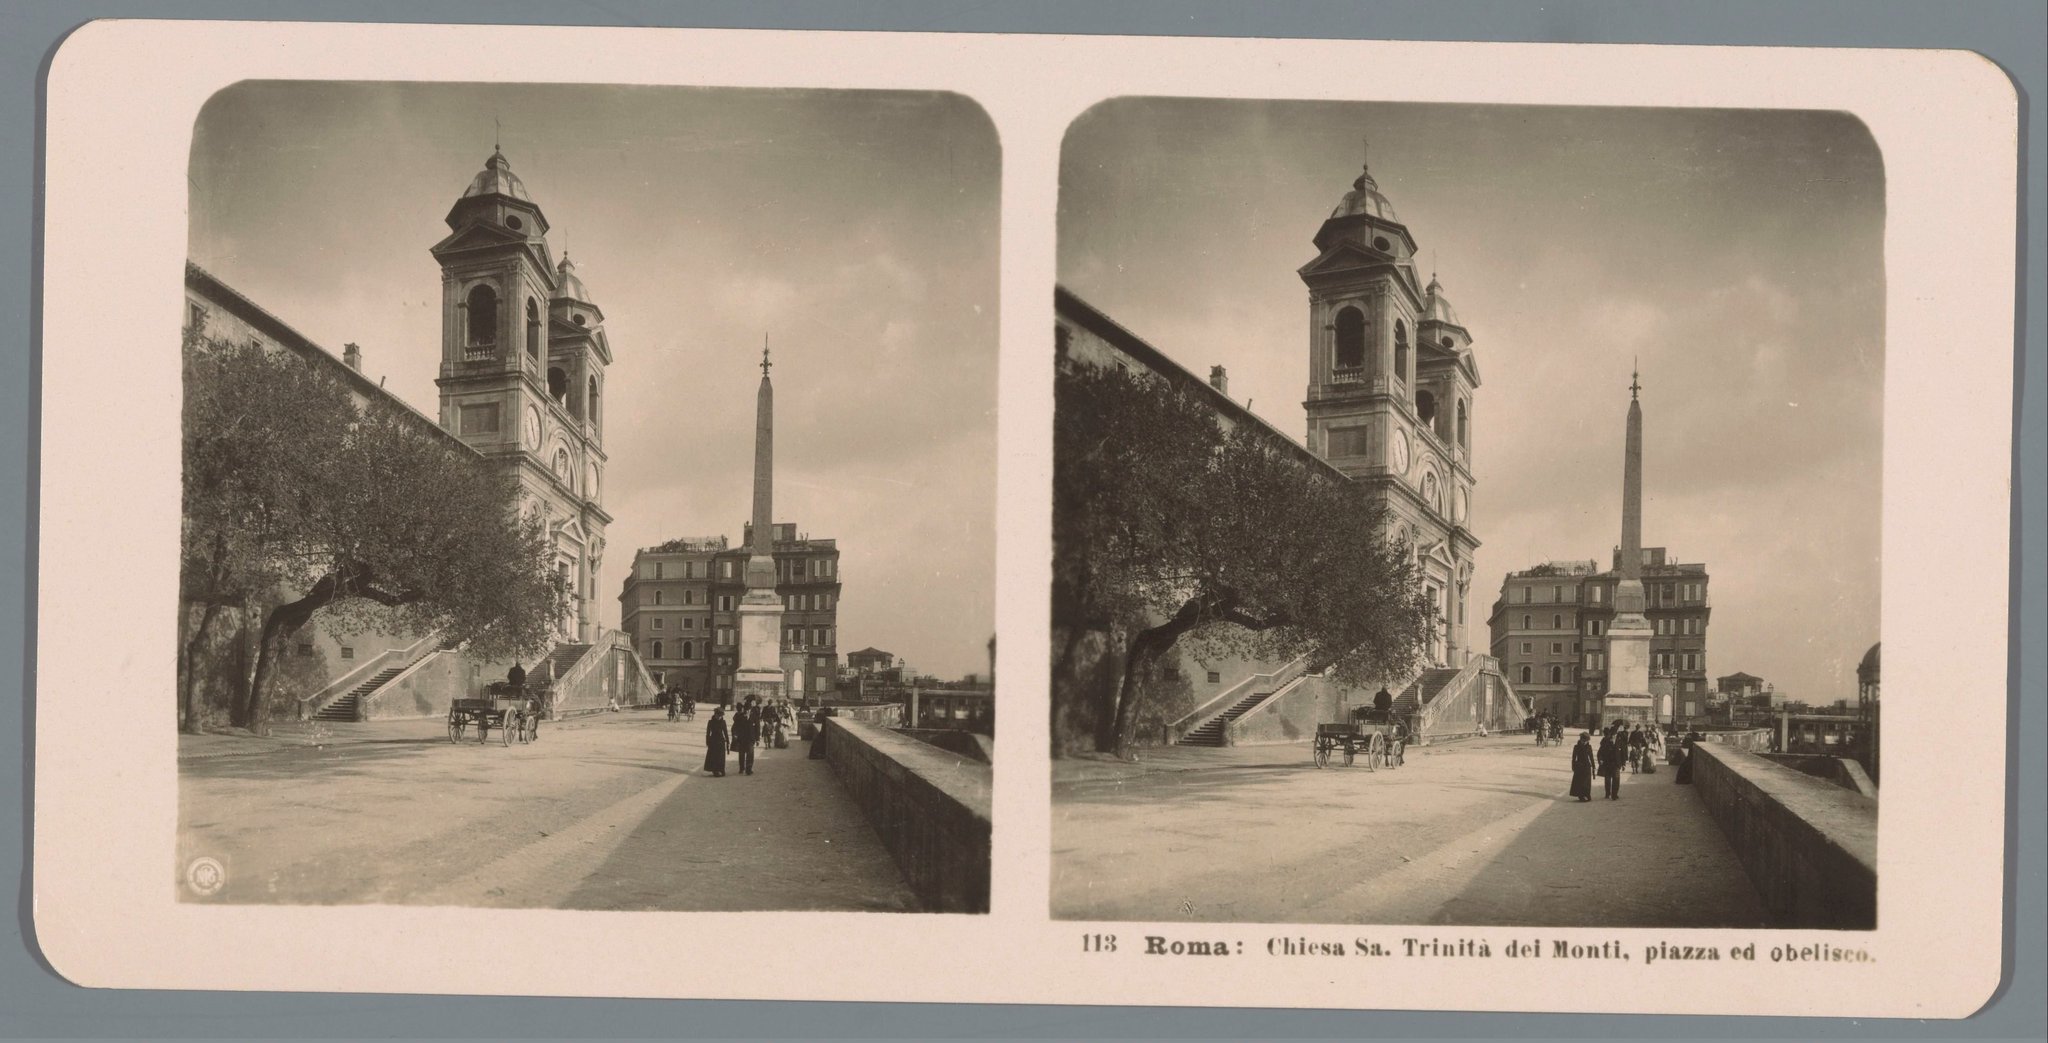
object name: stereograph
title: Exterieur van de Trinità dei Monti te Rome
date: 1900-1910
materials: cardboard, photographic support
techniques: gelatin silver print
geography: rome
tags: church (exterior), façade (of house or building)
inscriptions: inscription: ‘NPG’, number: ‘113’